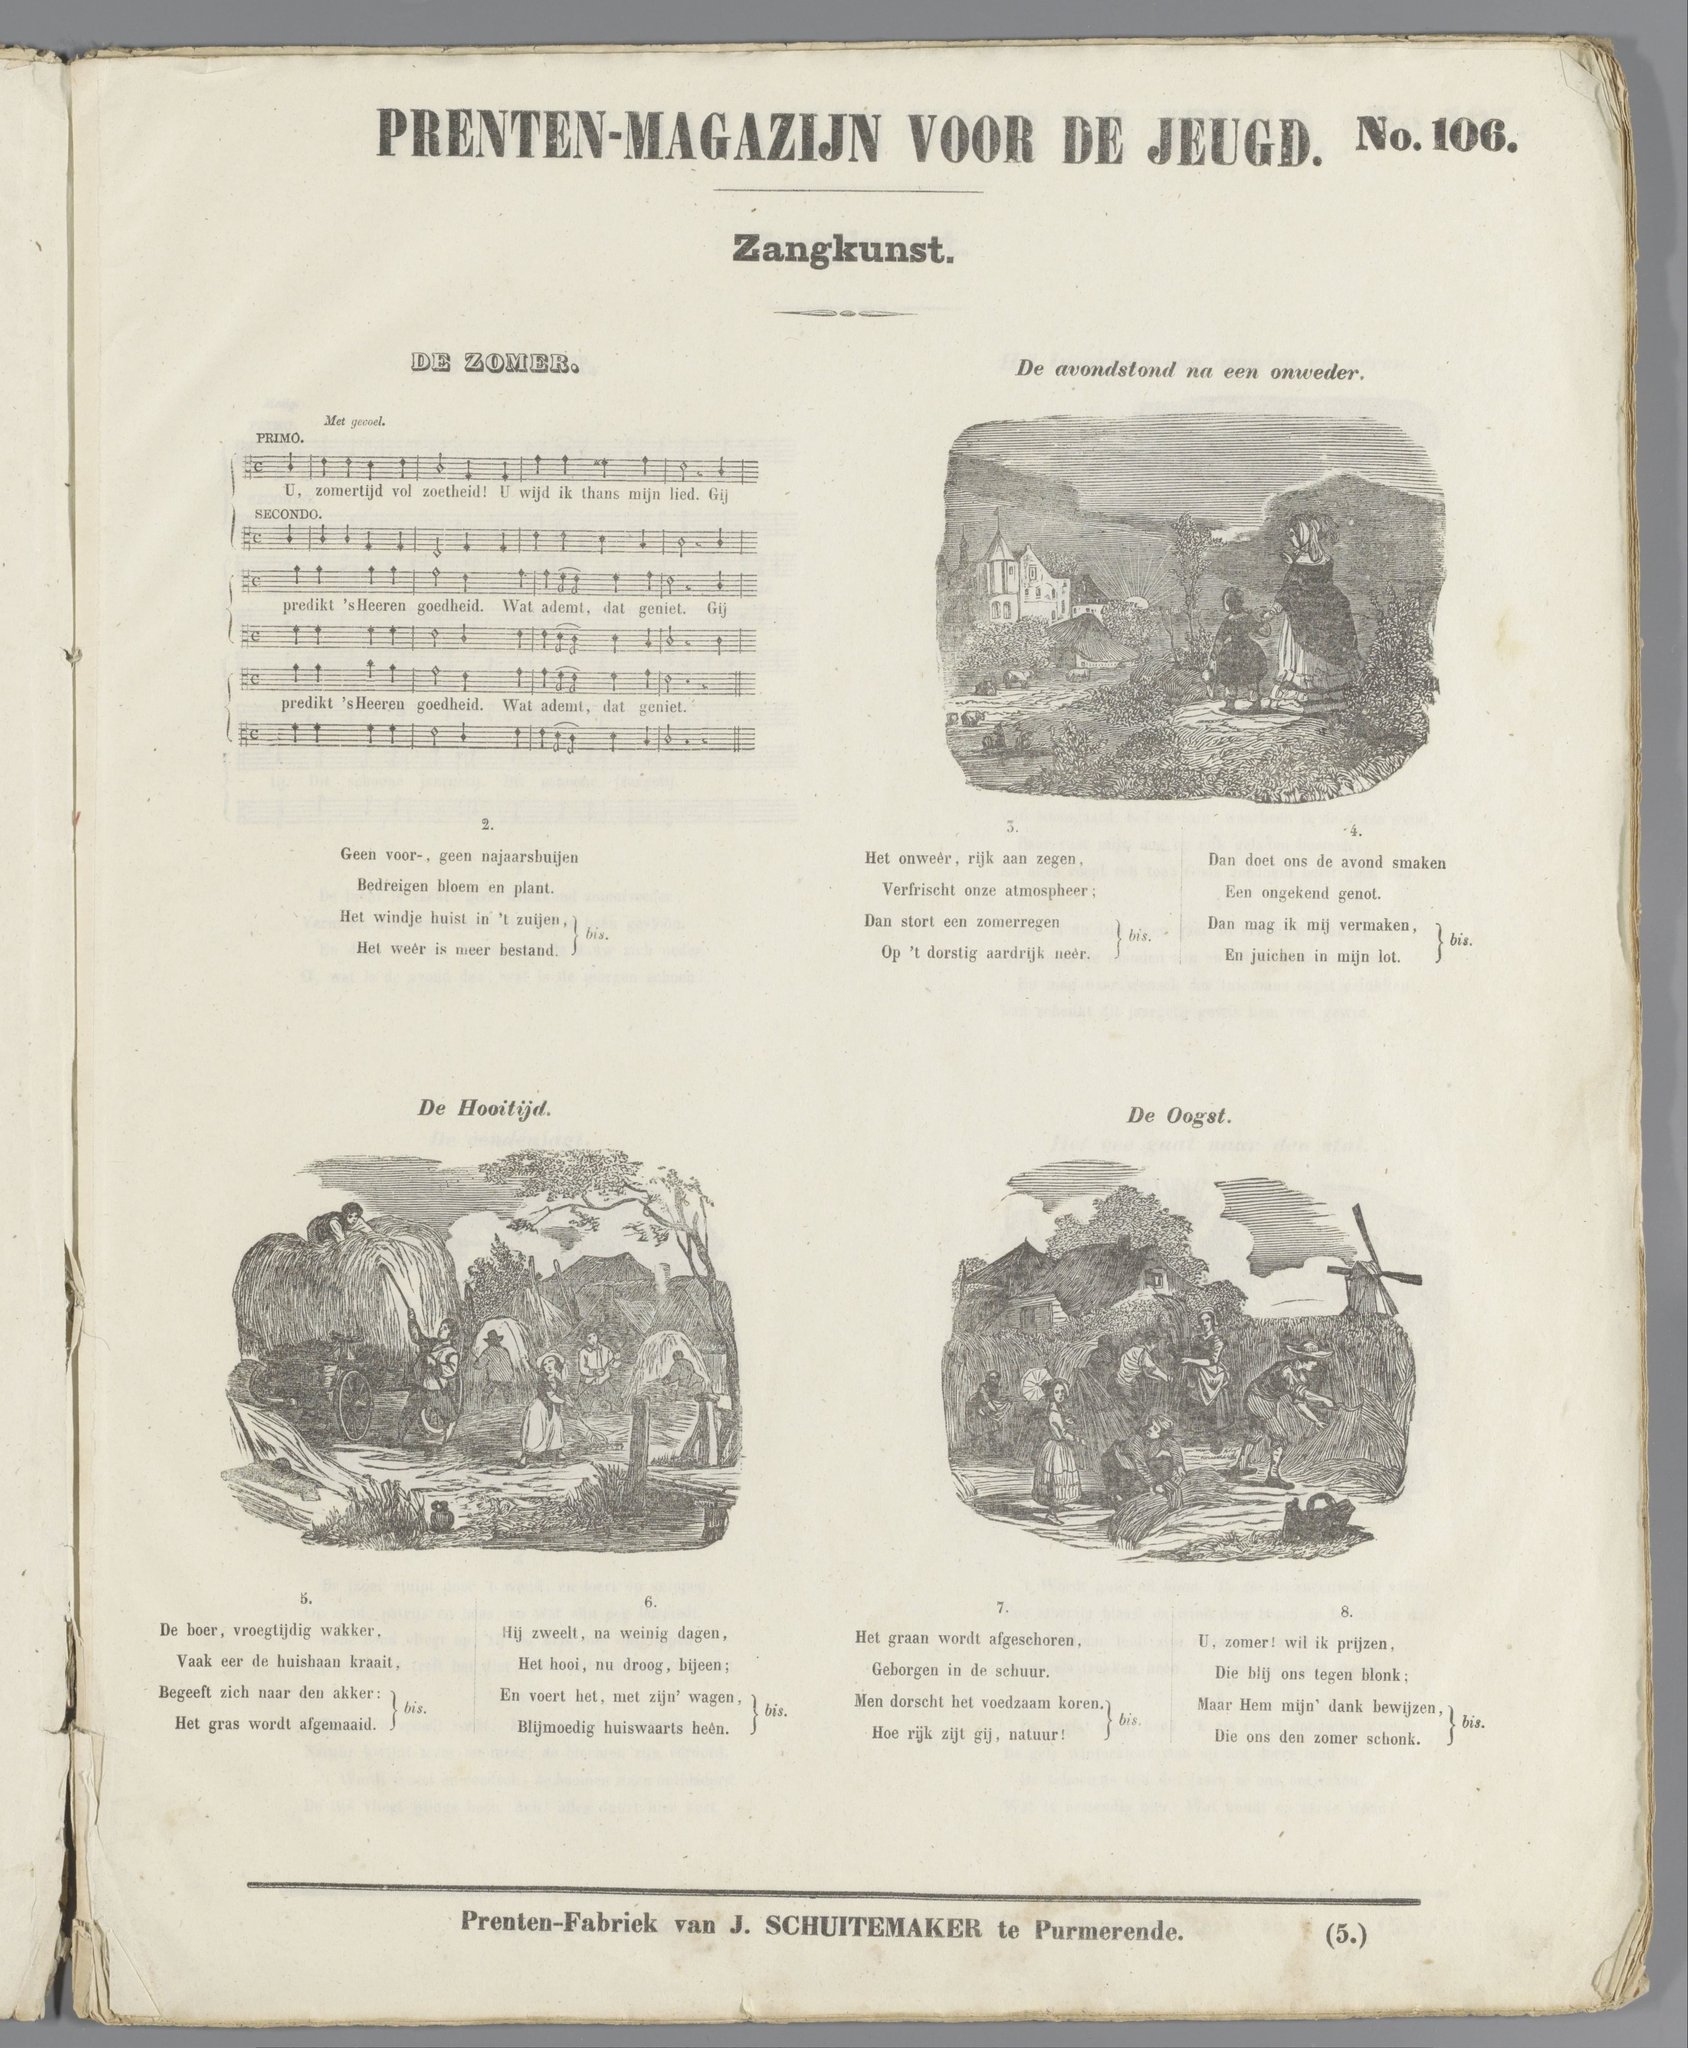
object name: print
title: Groot en goed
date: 1853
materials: paper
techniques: letterpress printing, engraving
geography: purmerend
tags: summer ~ human activities (the four seasons of the year), printed edition of musical score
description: Blad met muziekstuk 'De Zomer' en 3 voorstellingen: de avondstond na onweer, de hooitijd en de oogst. Onder de voorstellingen diverse coupletten van het muziekstuk. Genummerd rechtsboven: No. 106, linksonder: (5.).